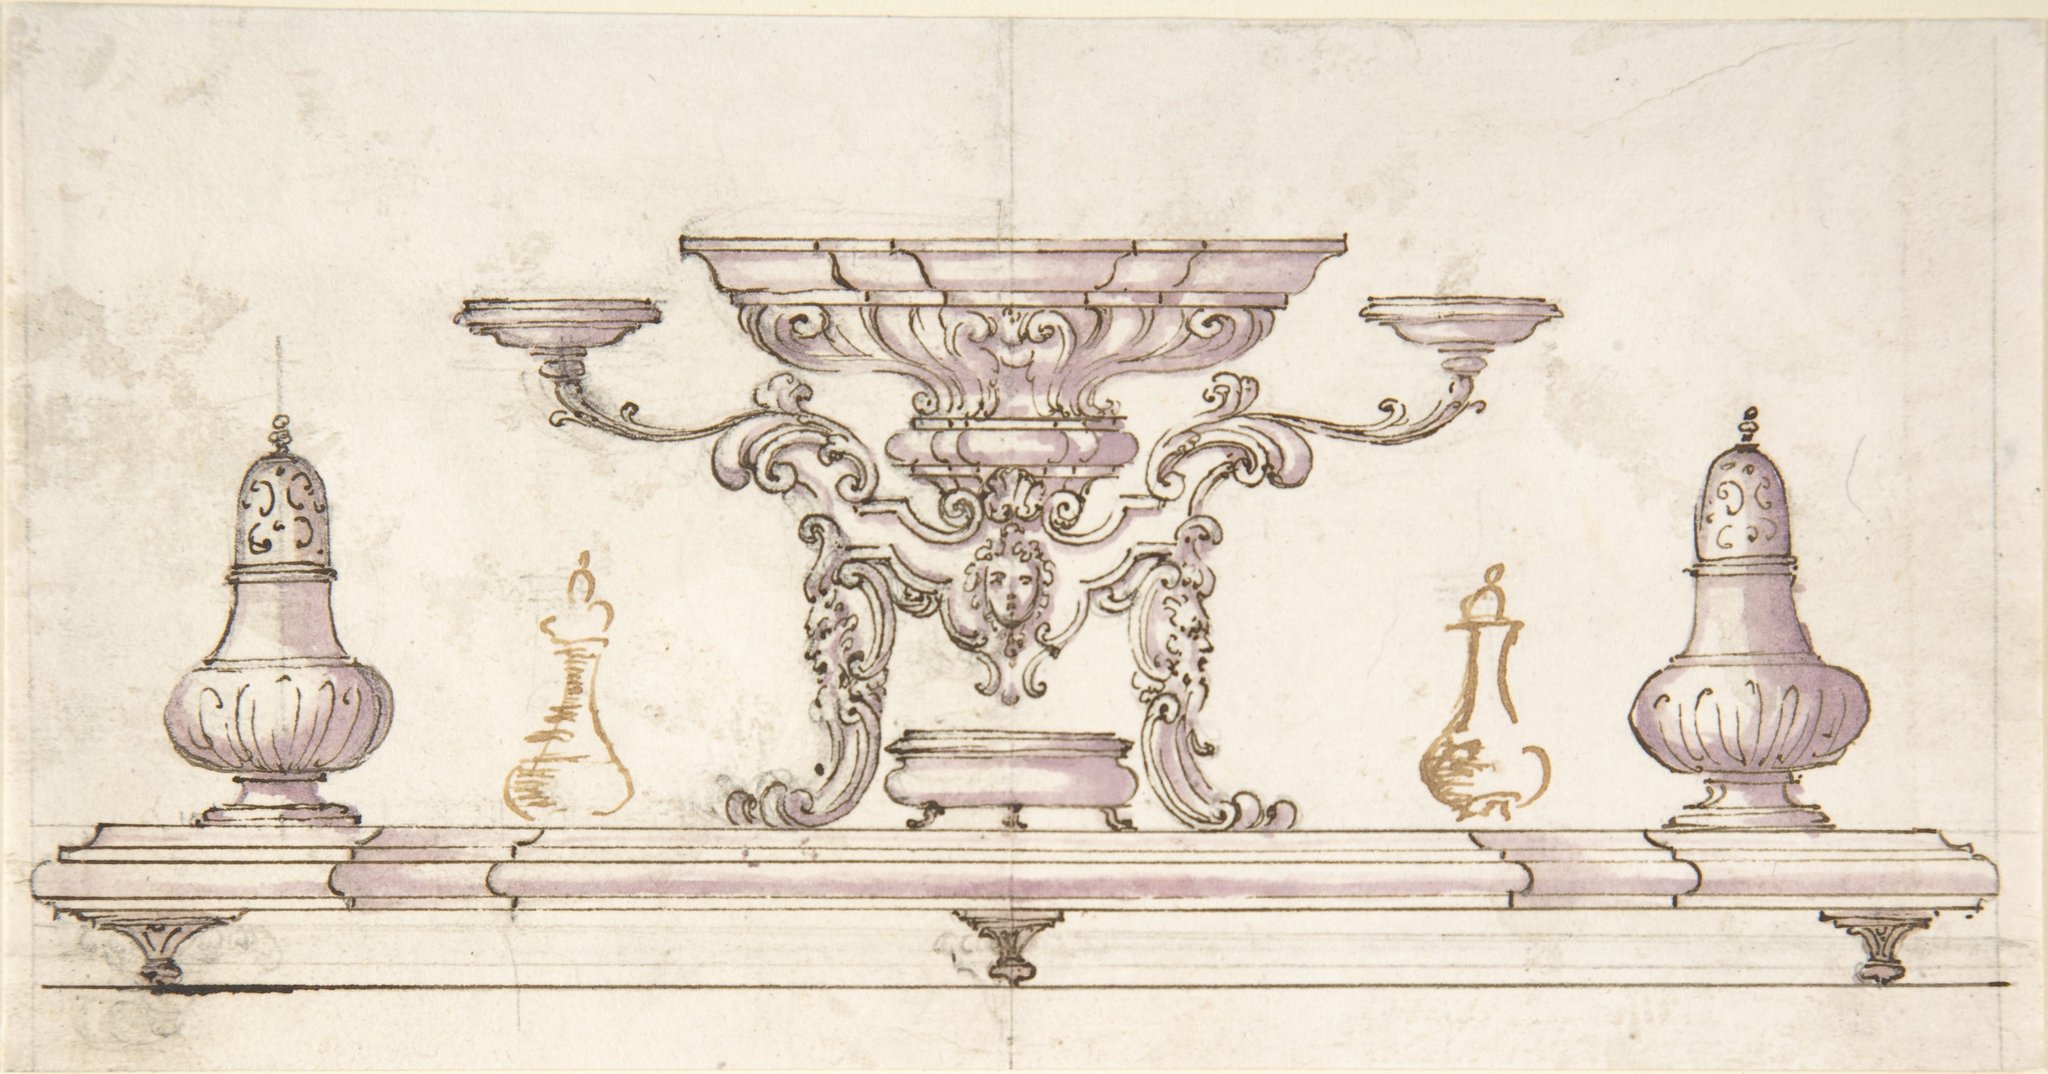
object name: drawing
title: Drawing for Centerpiece and Salt Cellars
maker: anonymous, italian, 18th century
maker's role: artist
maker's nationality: italian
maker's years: 1700-1800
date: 1701-1800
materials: ink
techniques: pen, wash